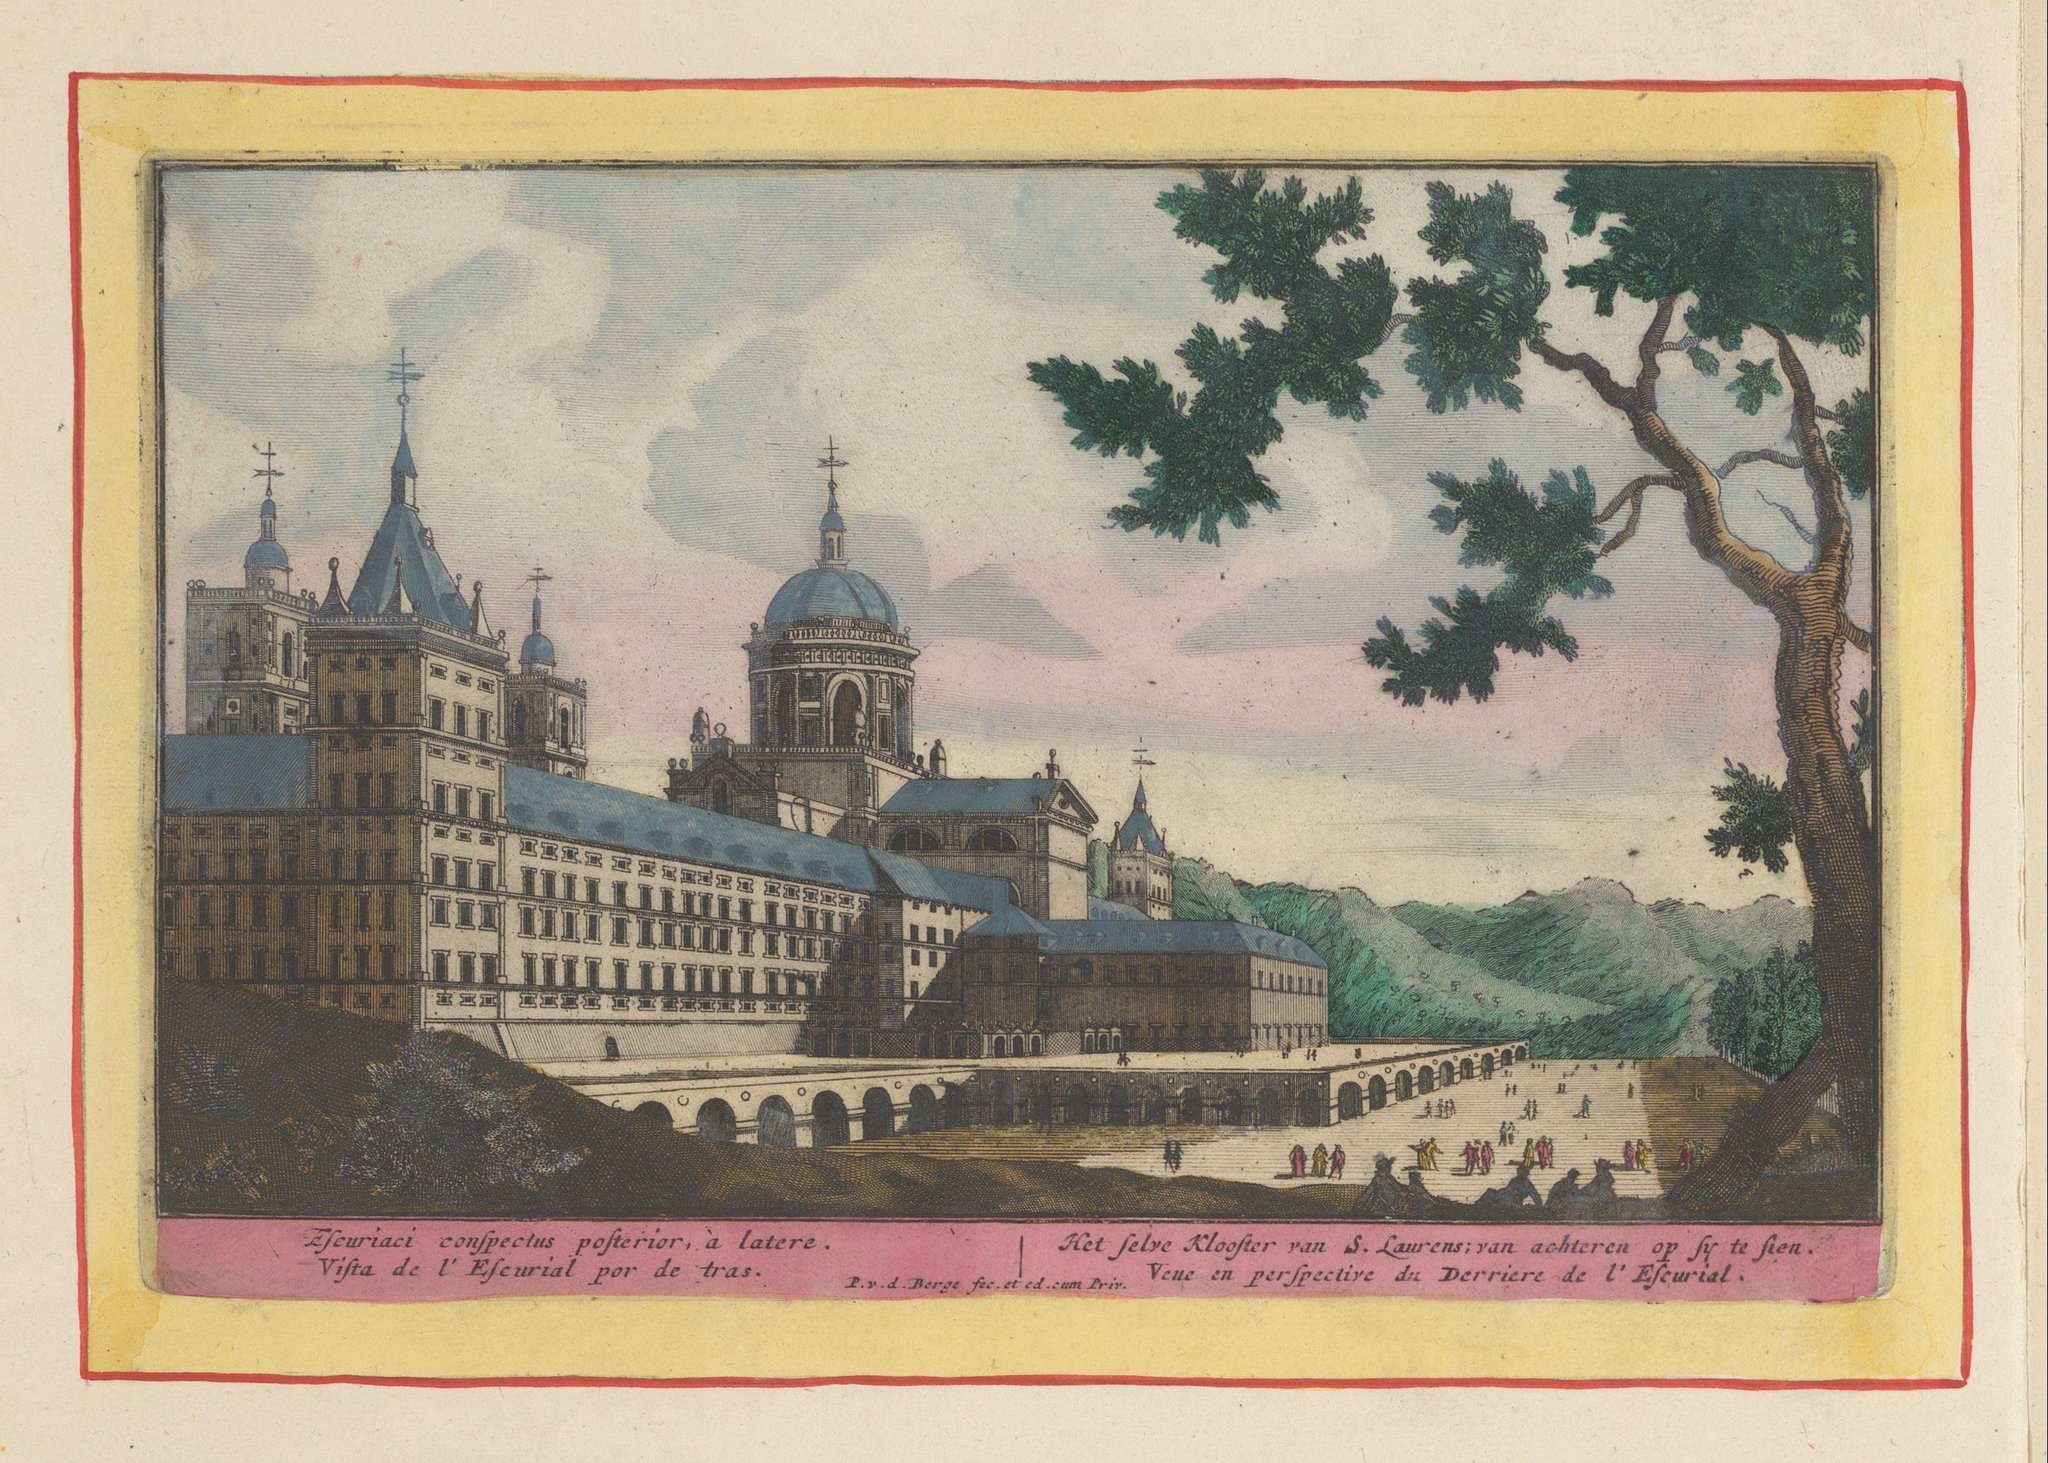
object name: print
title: Gezicht op de achterzijde van het Escorial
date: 1694-1737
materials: paper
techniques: etching, hand coloring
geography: amsterdam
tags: abbey, monastery, convent ~ roman catholic church, exterior ~ representation of a building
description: Prent uit: Theatrum Hispaniæ, exhibens regni urbes, villas ac viridaria magis illustria. Het aanmerkelykste en voortreffelykste in Spanjen (...). Amsterdam: Pieter van den Berge, ca. 1694-1737.